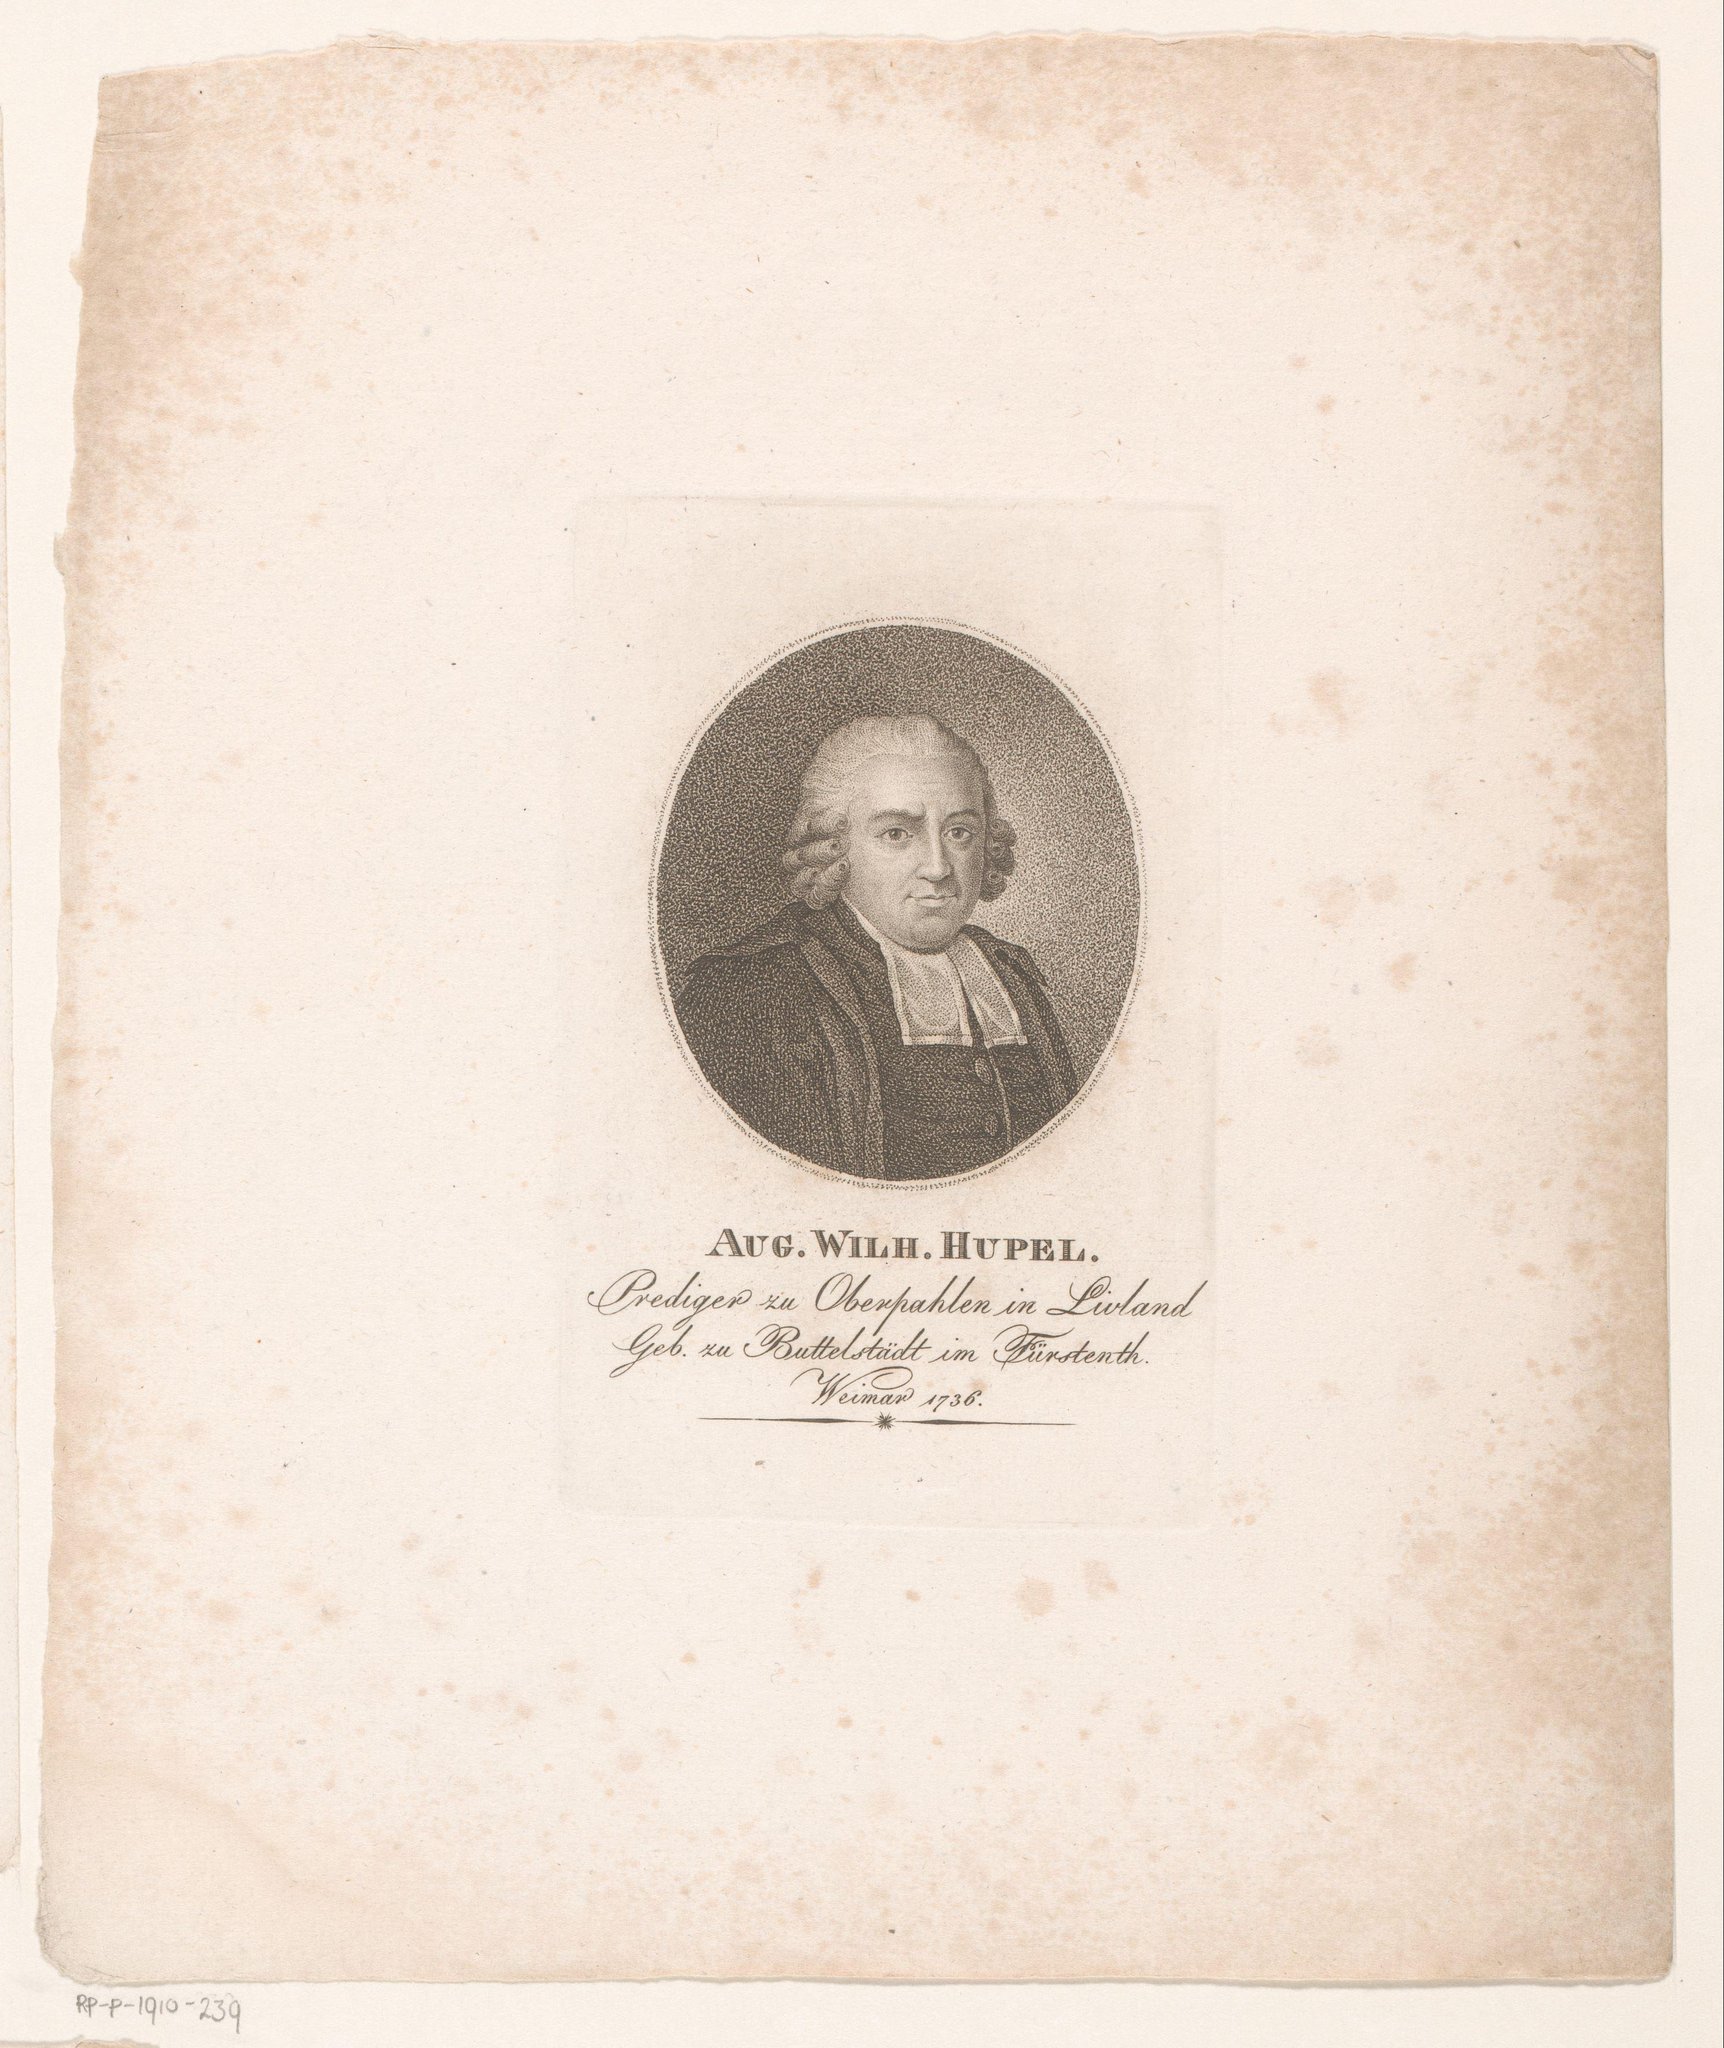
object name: print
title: Portret van August Wilhelm Hupel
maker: konrad westermayr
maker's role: print maker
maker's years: 1765-1834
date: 1775-1834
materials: paper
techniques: engraving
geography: germany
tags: historical persons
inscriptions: collector's mark: Lugt 2228